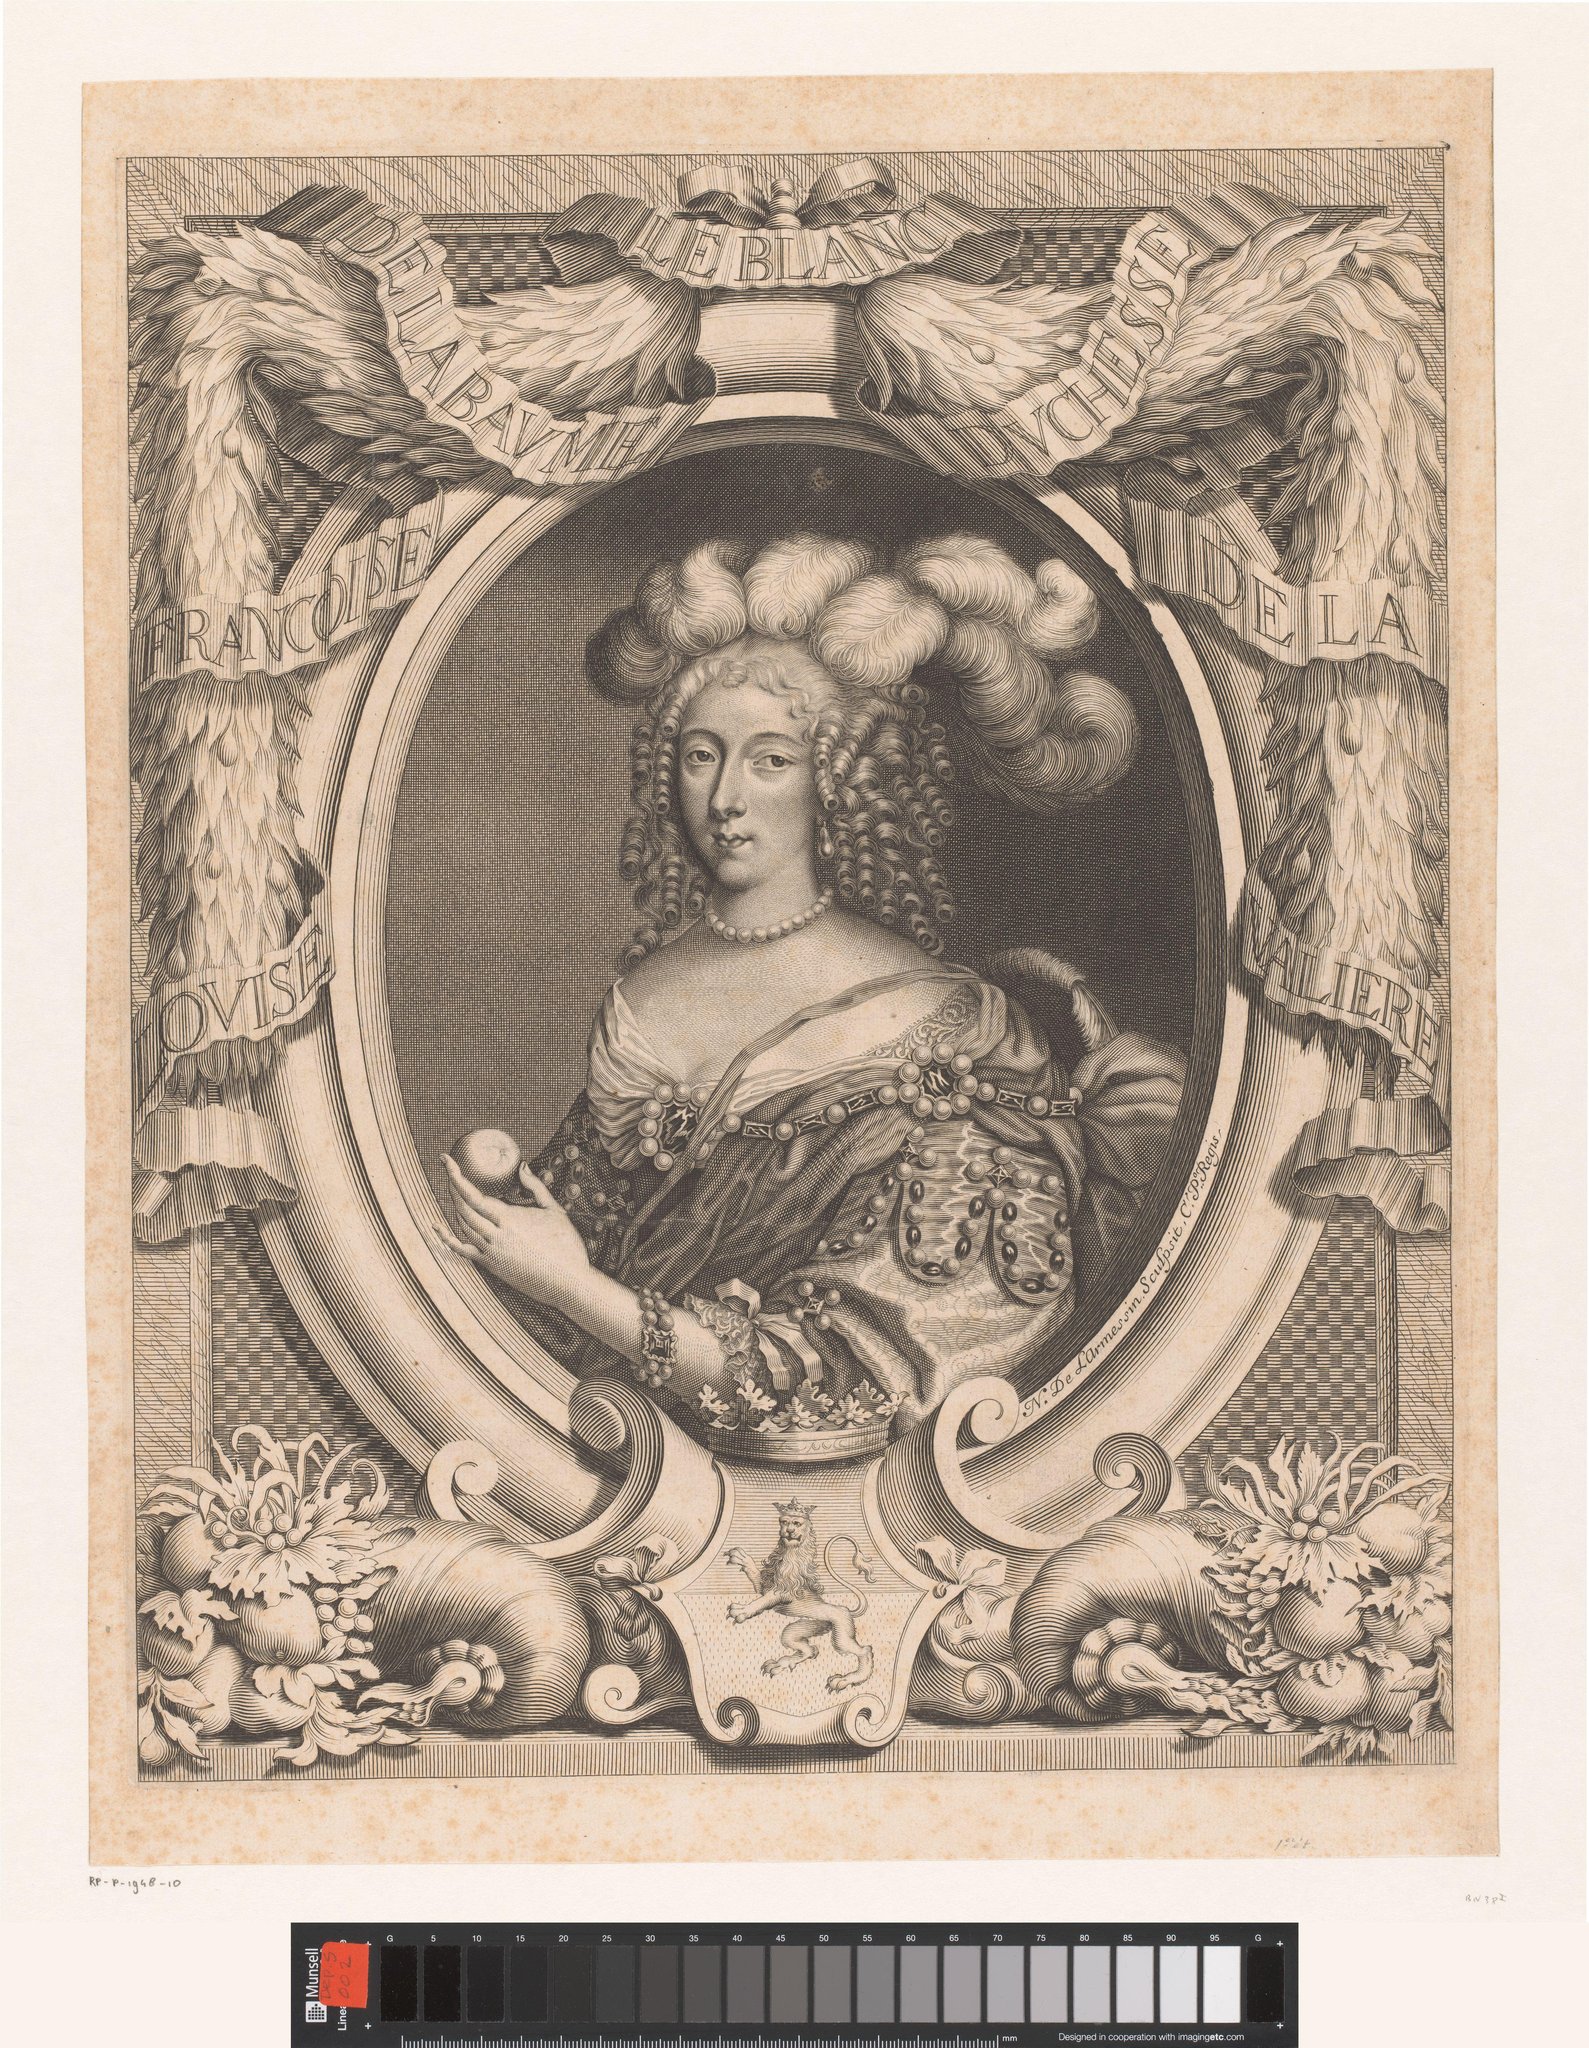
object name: print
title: Portret van Françoise-Louise de La Baume Le Blanc, hertogin van La Vallière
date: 1667-1674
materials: paper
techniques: engraving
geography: france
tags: paris, historical persons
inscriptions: inscription: ‘ACM’, collector's mark: Lugt 2228, inscription: ‘Son plus beau portrait/ HdG. 374’, collector's mark: Lugt 2004, inscription: ‘P 88/ Man.-’